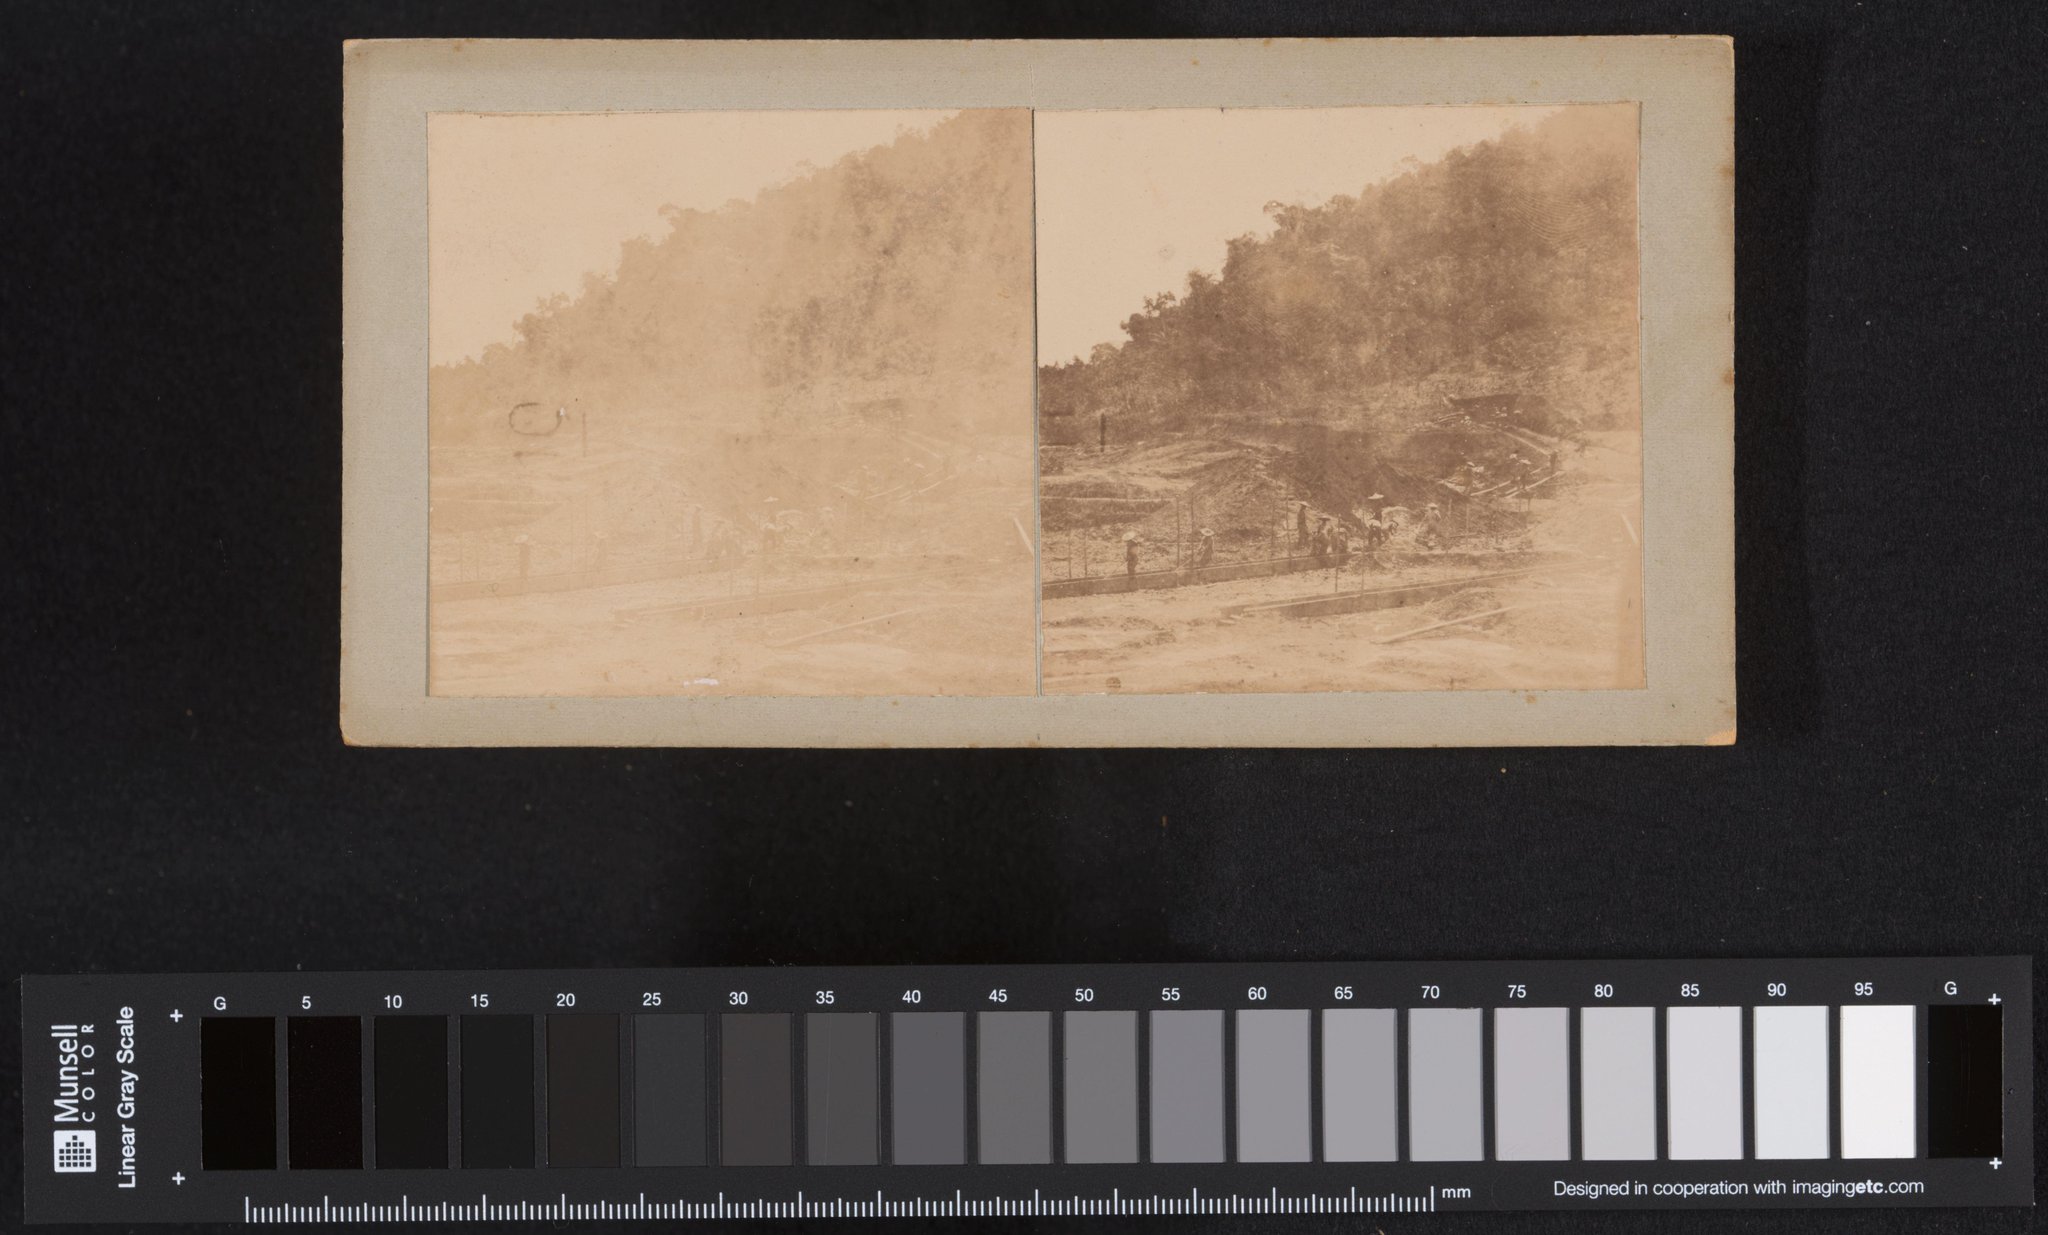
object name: stereograph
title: Tinmijn te Merawang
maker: robert julius boers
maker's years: 1867-1932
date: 1900-1922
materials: cardboard, photographic support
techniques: gelatin silver print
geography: bangka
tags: robert julius boers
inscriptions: inscription: ‘Erts waschen Mijn 14 Merawang’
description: Gezicht in een open tinmijn te Merawang op Banka. Onderdeel van een groep stereofoto's van Robert Julius Boers, chef van het staatsbedrijf de Banka-tinwinning op Banka, uit de periode ca. 1900-1922.